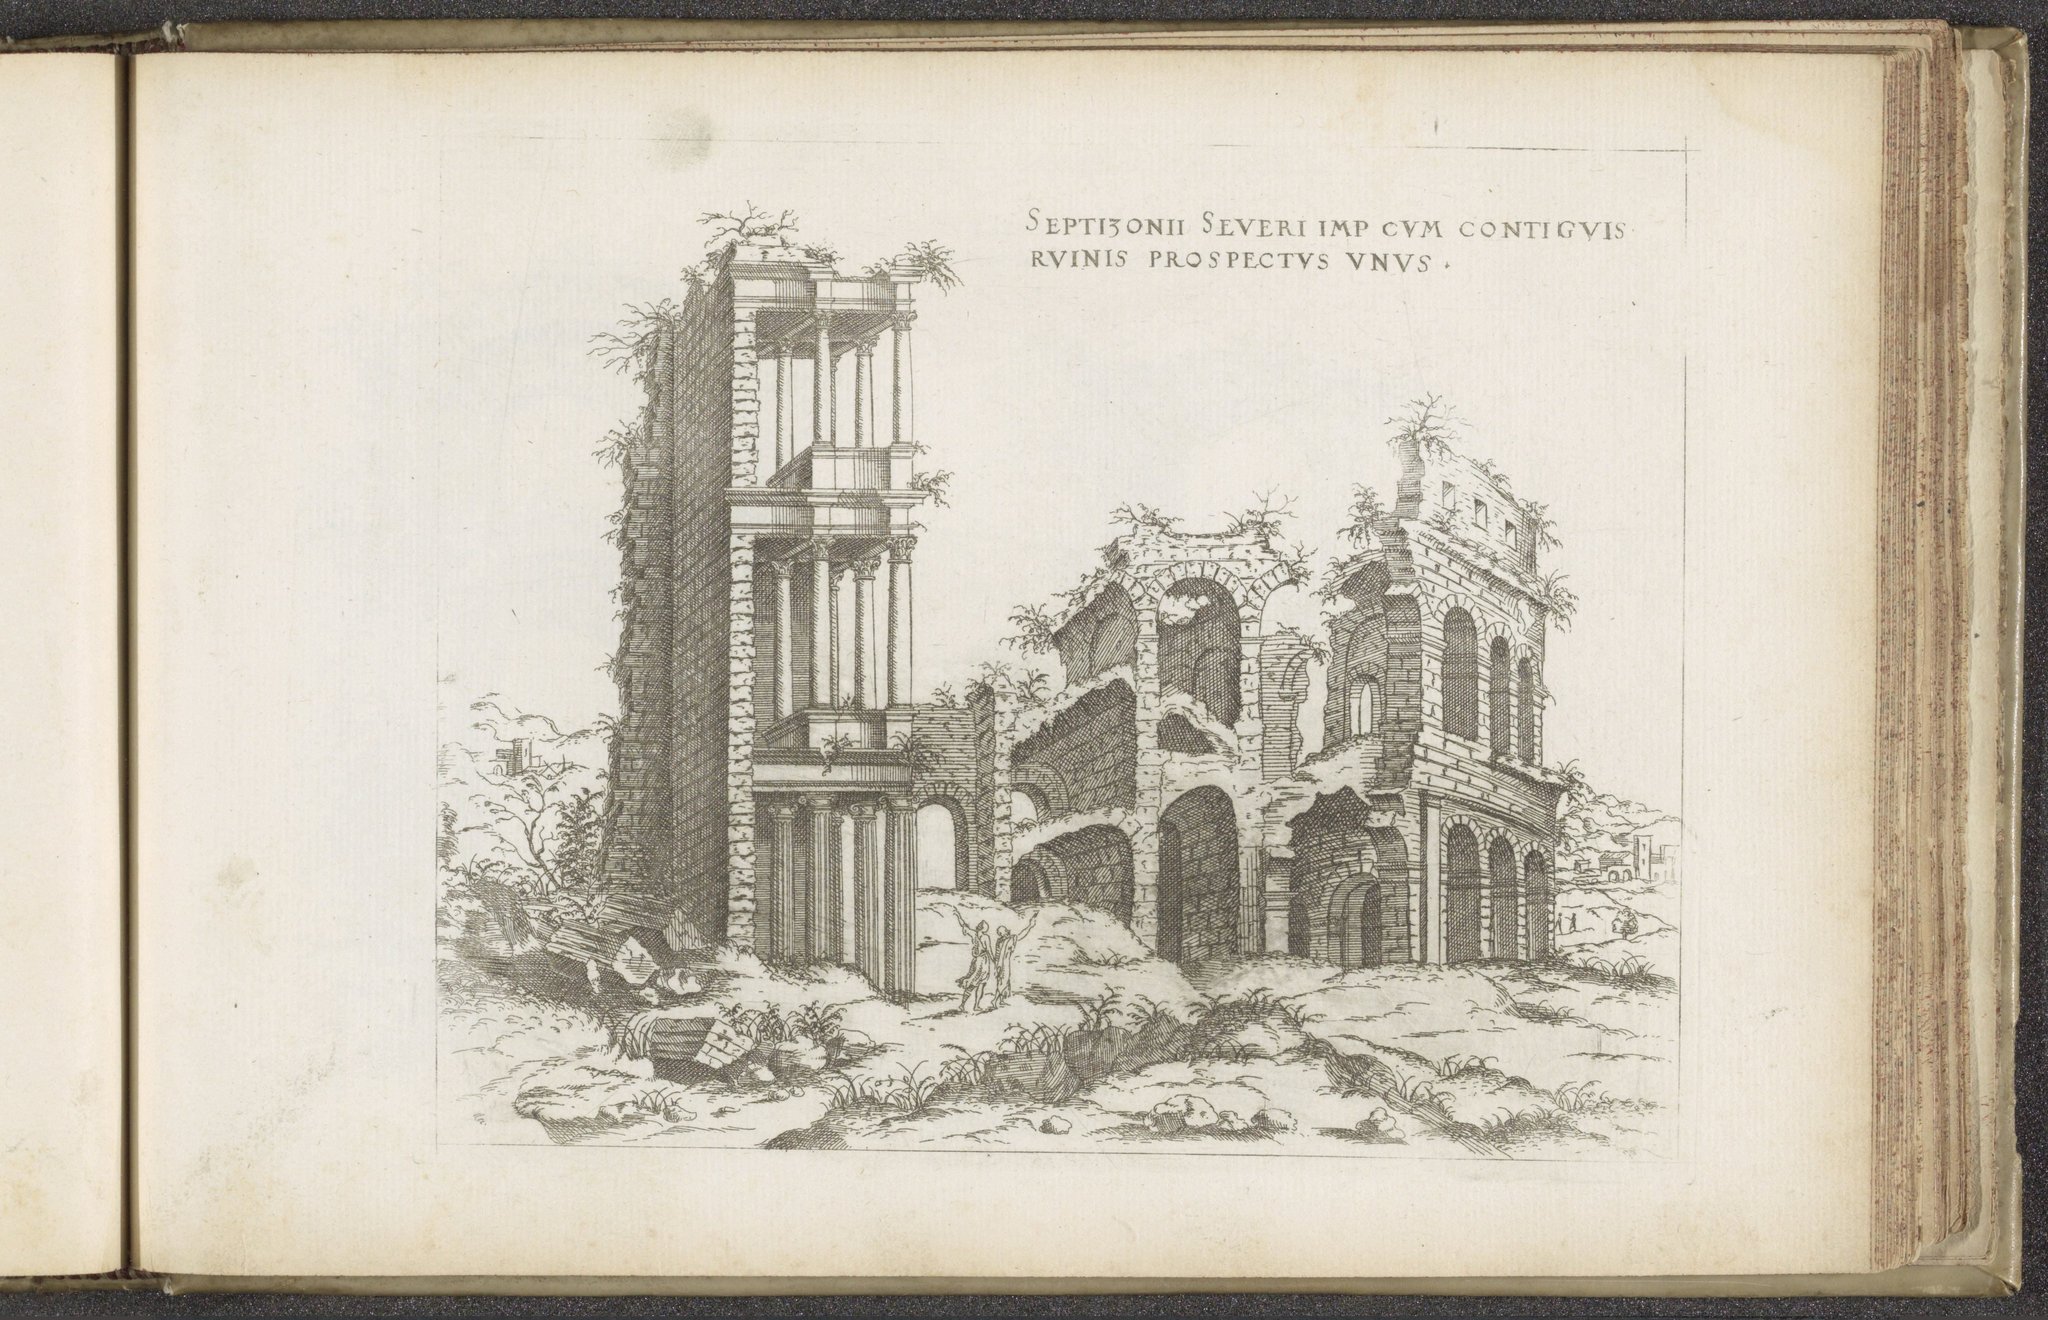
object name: album leaf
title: Septizonii Severi Imp Cum Contiguis Ruinis Prospectus Unus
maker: jacques androuet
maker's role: draughtsman, print maker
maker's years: 1515-1584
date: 1551-1584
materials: paper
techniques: etching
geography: france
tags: ruin of a building ~ architecture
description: Gezicht op het Septizonium en het Colosseum in Rome. Twee mannen bekijken de ruïnes en wijzen met hun handen naar de gebouwen. Deze prent maakt deel uit van een album.